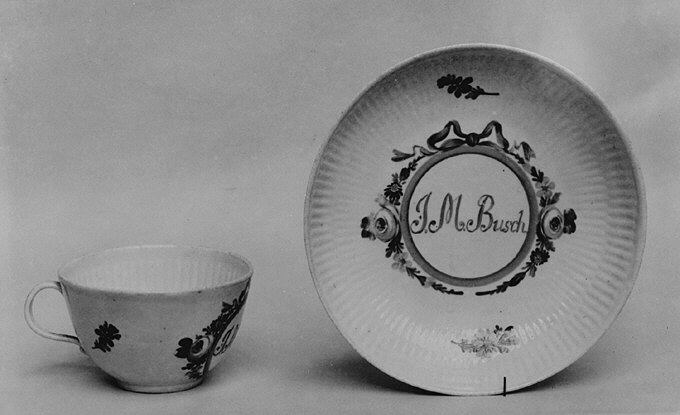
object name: cup and saucer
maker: wallendorf porcelain manufactory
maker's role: manufactory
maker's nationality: german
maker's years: 1764-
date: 1762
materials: hard paste porcelain